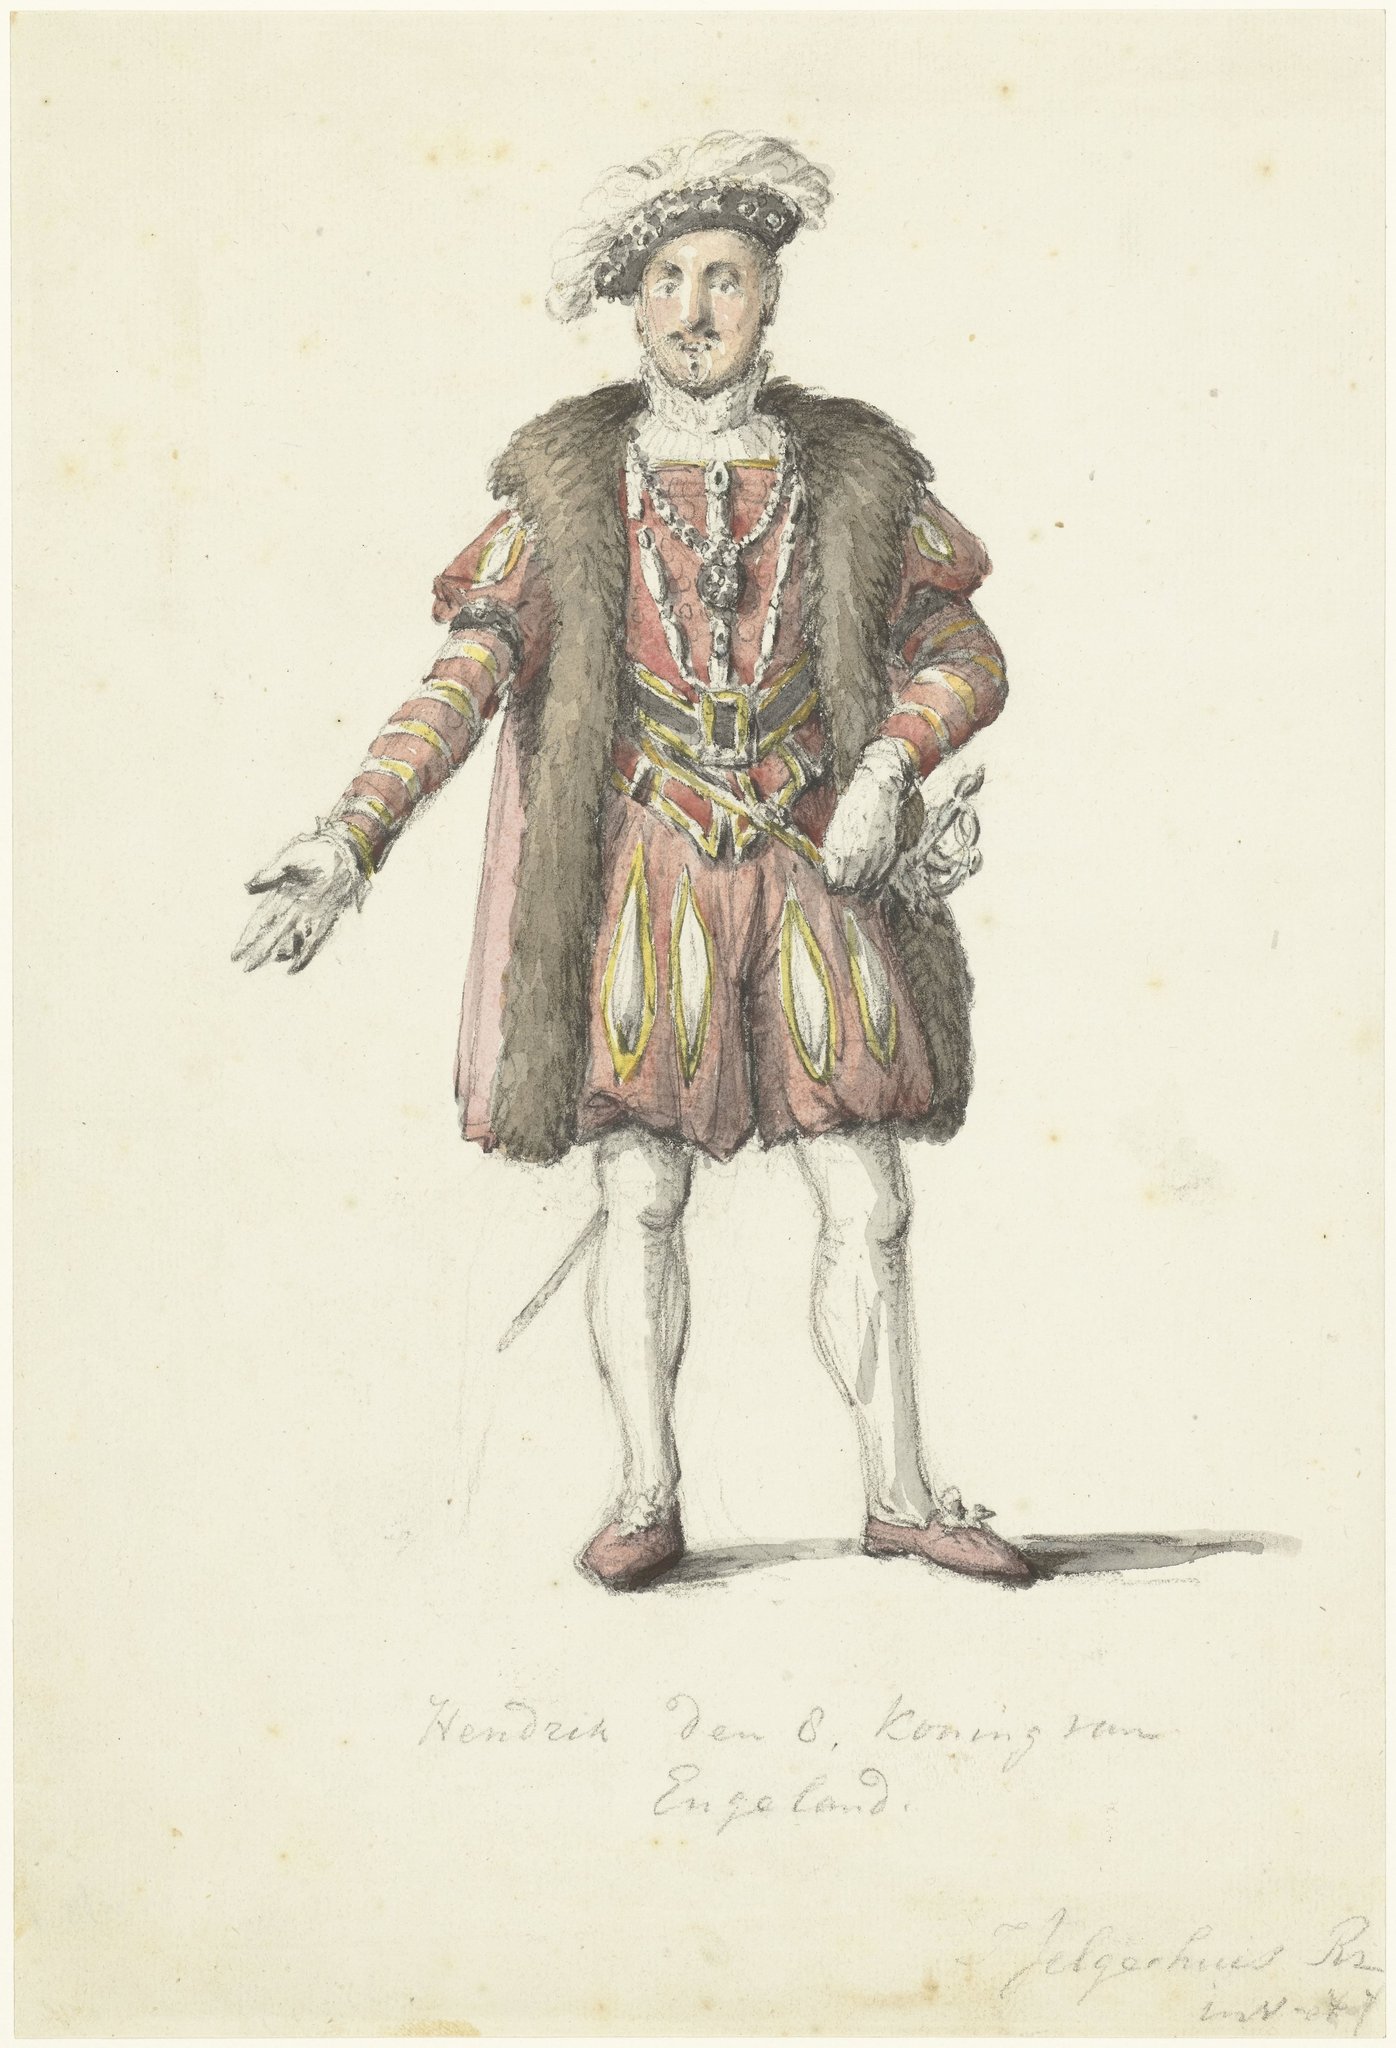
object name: drawing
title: Een acteur als koning Hendrik VIII van Engeland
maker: johannes jelgerhuis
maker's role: draughtsman, painter, print maker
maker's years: 1770-1836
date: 1780-1836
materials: chalk, paper, watercolor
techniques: brush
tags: historical persons, actor (on the stage)